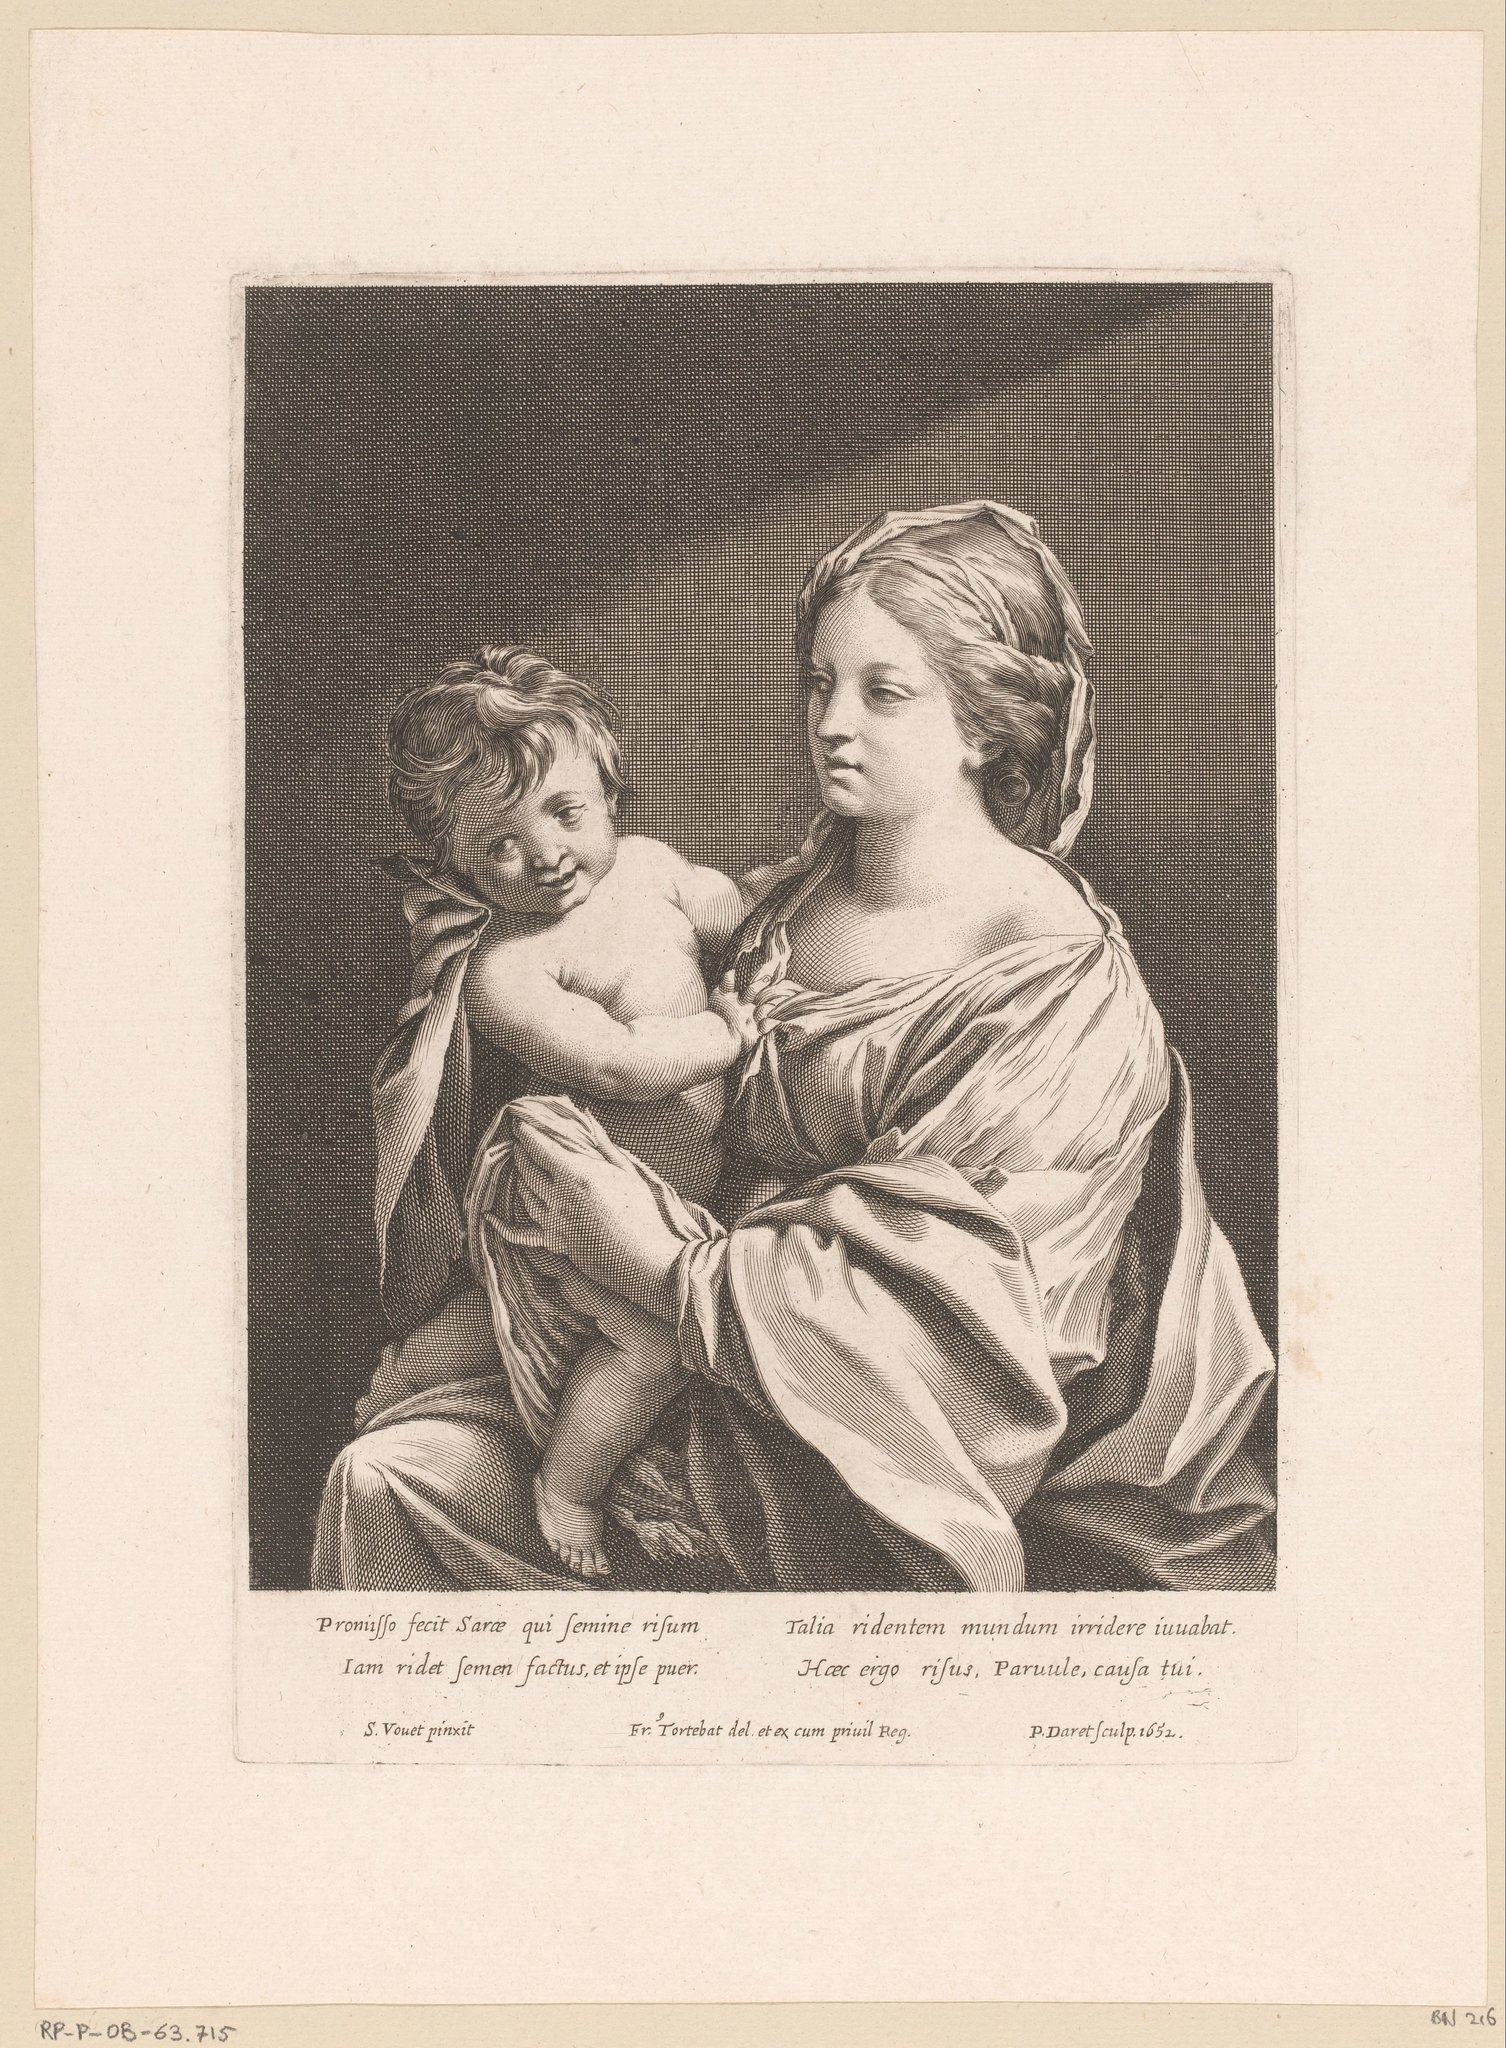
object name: print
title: Maria met Kind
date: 1652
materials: paper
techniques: engraving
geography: france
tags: madonna: i.e. mary with the christ-child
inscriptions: collector's mark: Lugt 240